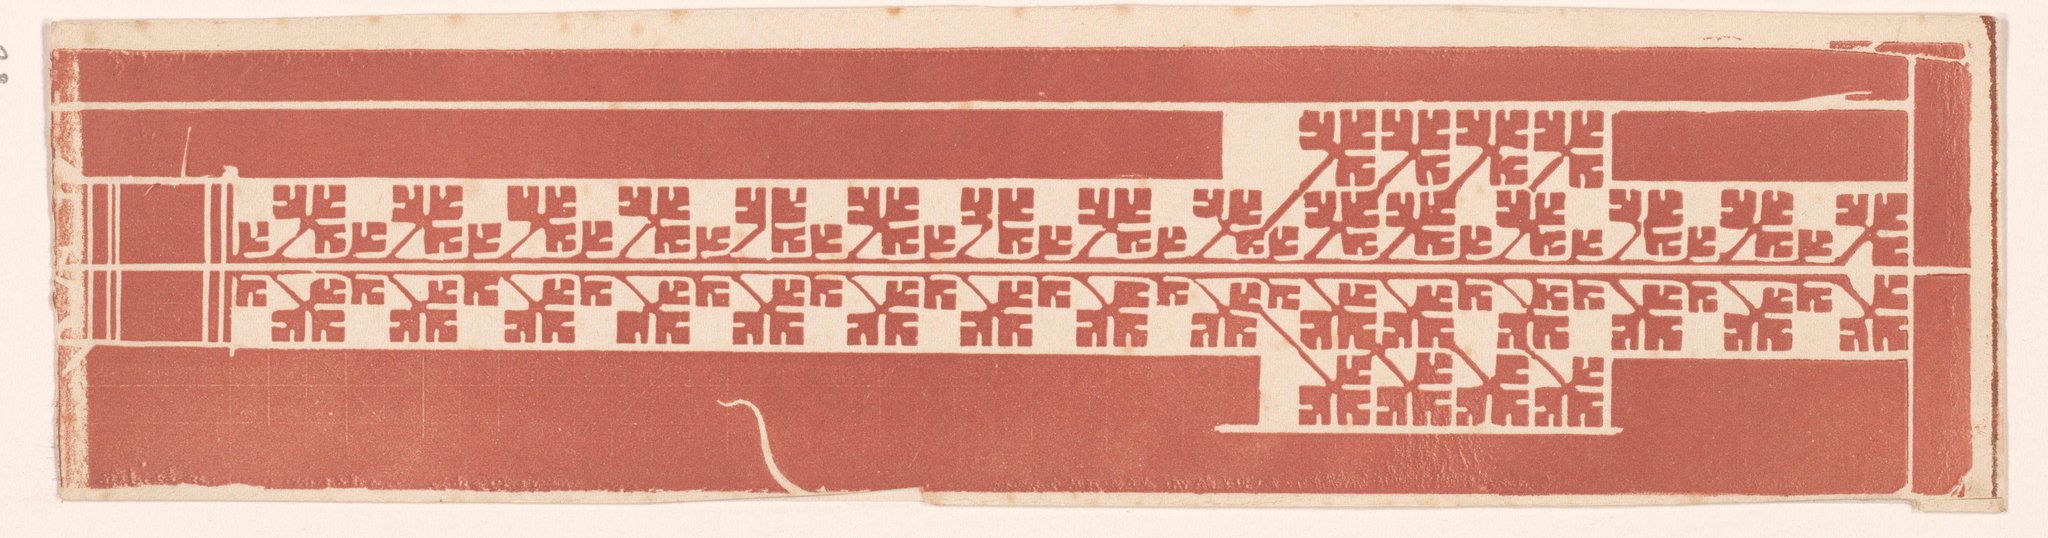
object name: print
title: Ornament met bladeren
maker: bernard willem wierink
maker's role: draughtsman, print maker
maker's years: 1856-1939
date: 1910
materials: paper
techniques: relief print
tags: fable of reynard the fox, foliage, tendrils, branches ~ ornament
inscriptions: collector's mark: Lugt 2228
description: Ontwerp voor: Streuvels, Stijn (Frank Lateur). Reinaert de Vos naar verschillende uitgaven van het middeleeuwsche epos. Amsterdam: L.J. Veen, 1910. Deze prent is vermoedelijk een plaatsnede, ook al wordt in de literatuur veelal gesproken over een houtsnede. Voor zover Wierink zijn prenten in hoogdruk zelf nader heeft omschreven, heeft hij altijd de term 'plaatsnede' gebruikt.